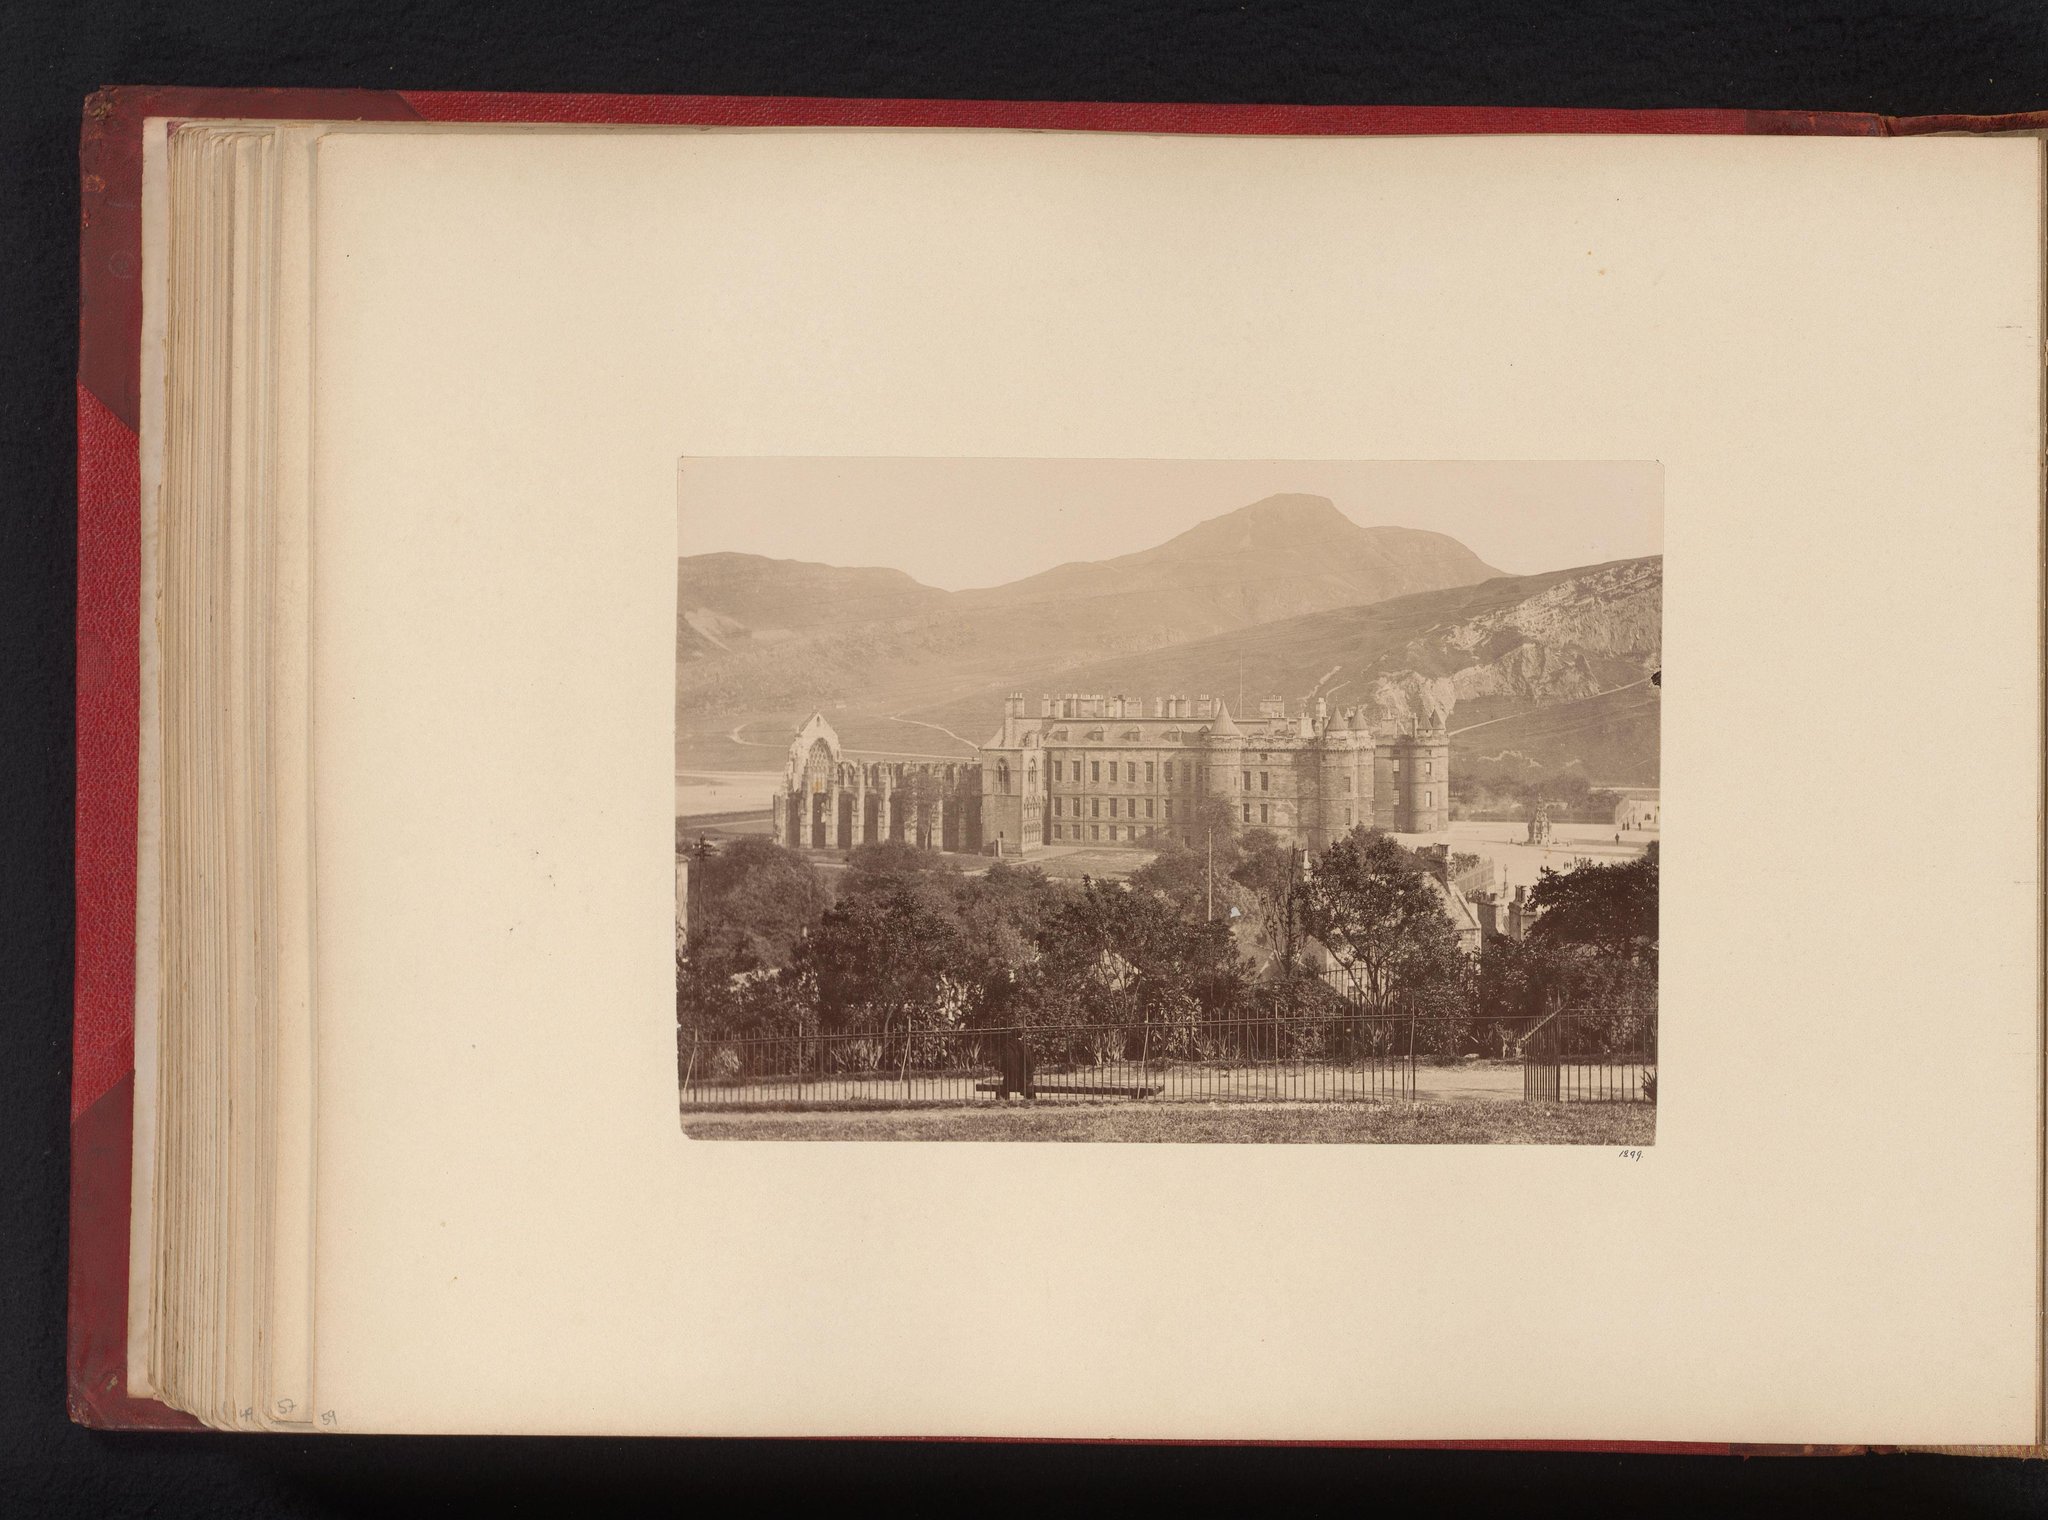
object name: photograph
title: Gezicht op een kasteel met afgebrande kerk, vermoedelijk te Schotland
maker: Anonymous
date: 1899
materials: photographic support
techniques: albumen print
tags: landscape with tower or castle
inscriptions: annotation: ‘1899’